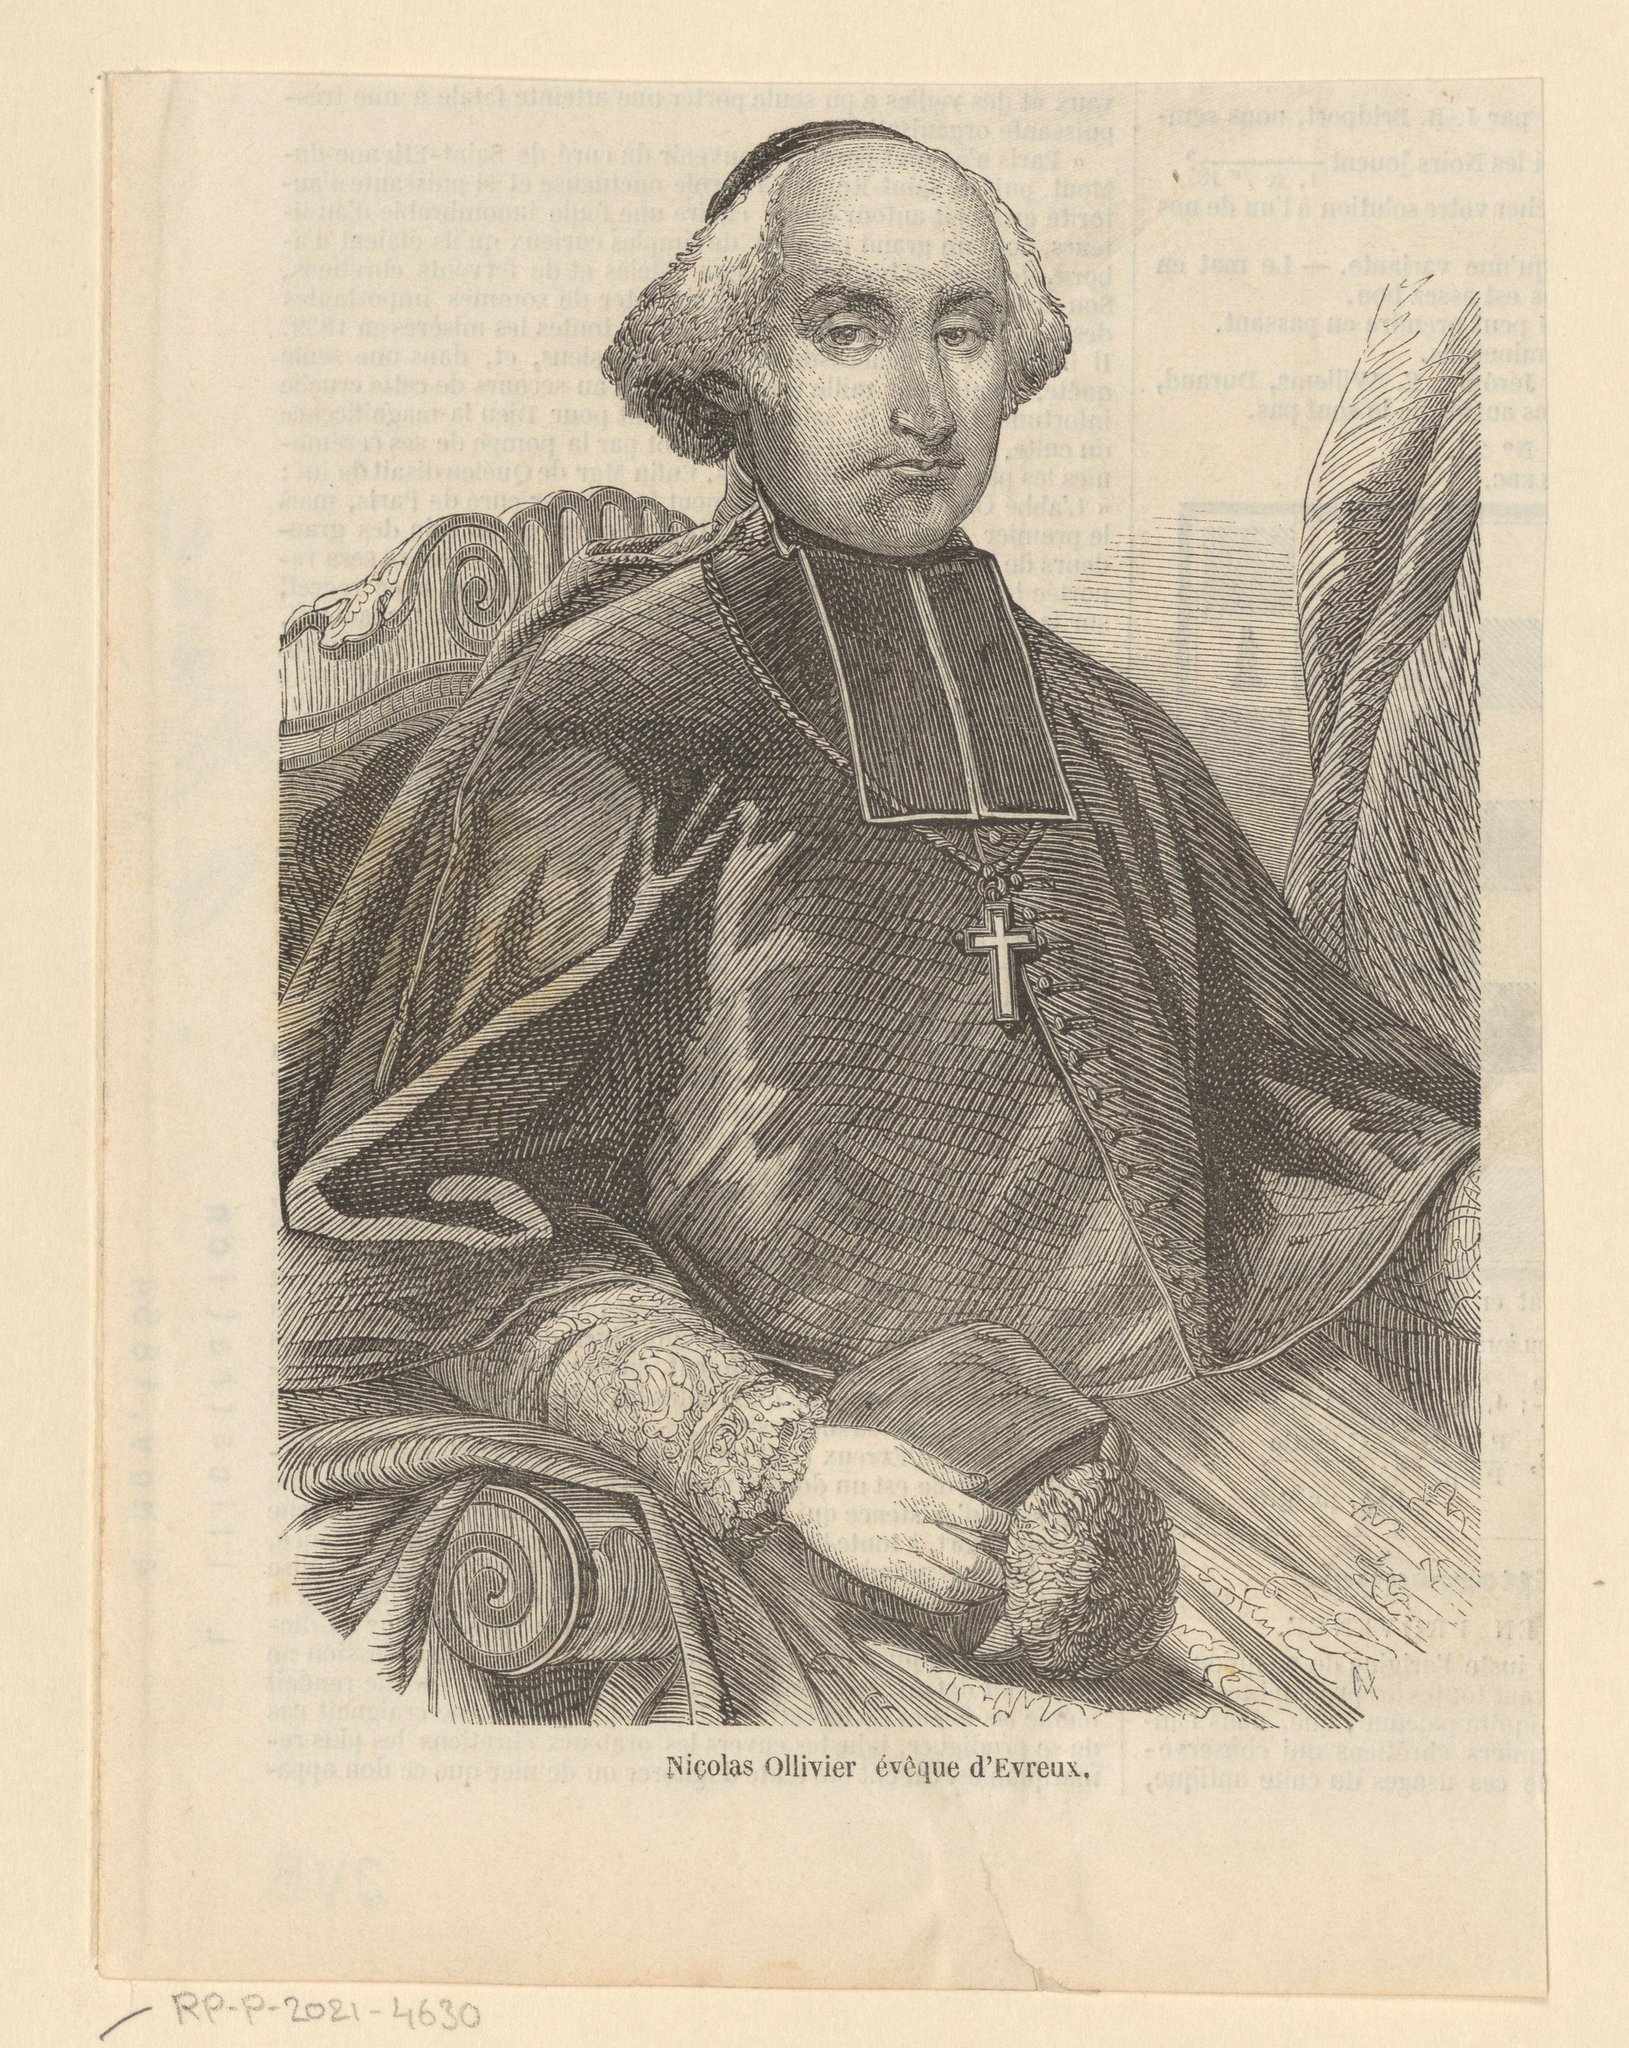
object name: print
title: Portret van Nicolas-Théodore Olivier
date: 1854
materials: paper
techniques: letterpress printing, engraving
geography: paris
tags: paris, historical persons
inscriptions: collector's mark: ‘JVB’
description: Prent uit: L'Illustration, 4 november 1854.